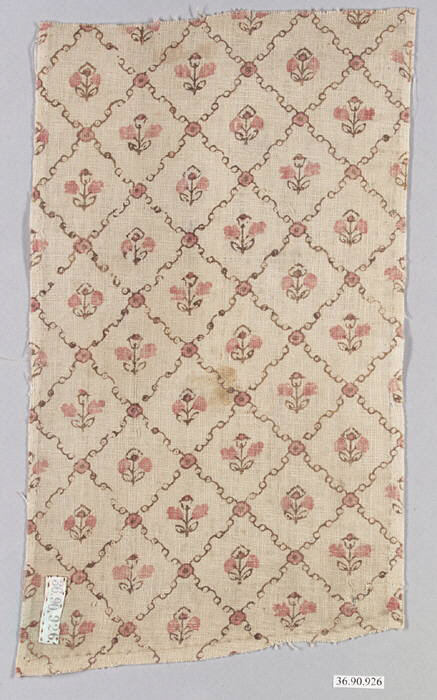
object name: piece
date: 1767-1800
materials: cotton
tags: flowers,leaves